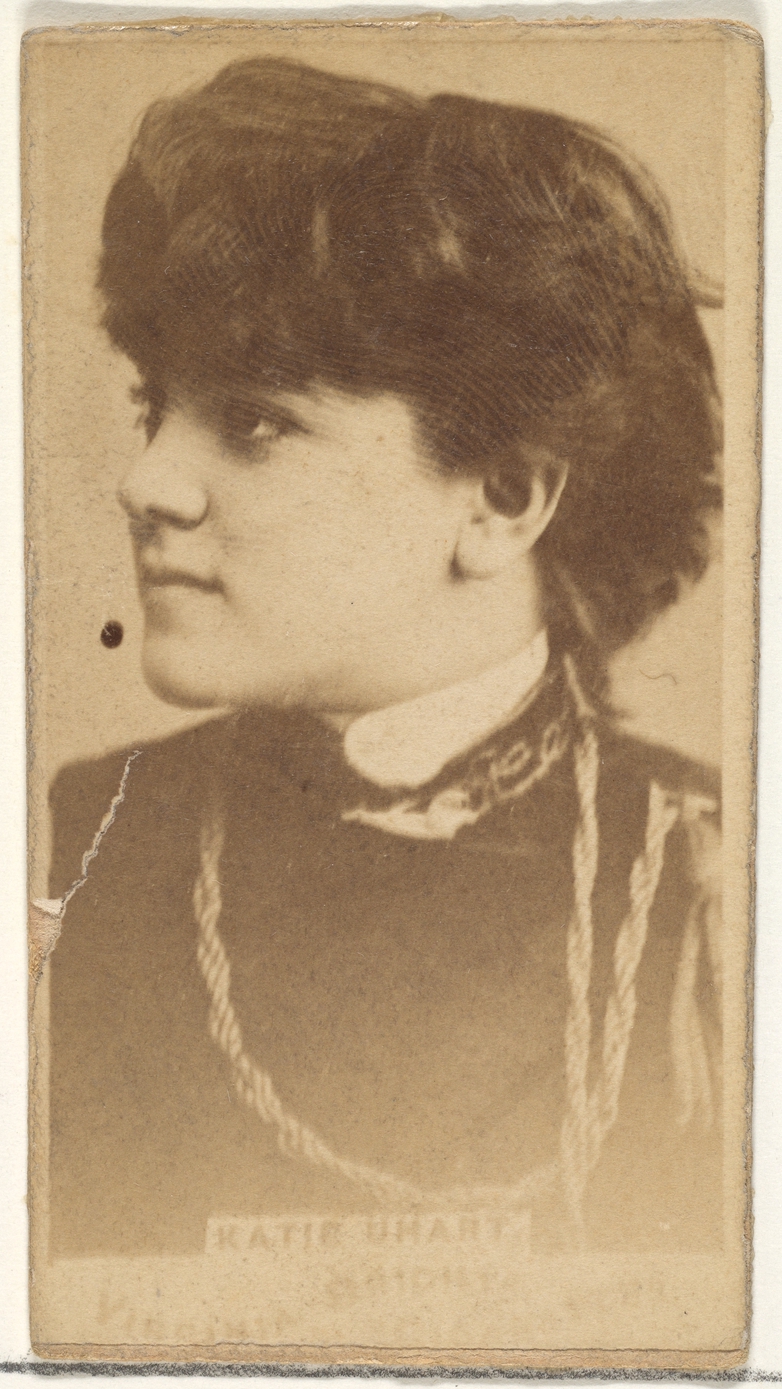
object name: photograph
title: Katie Uhart, from the Actors and Actresses series (N45, Type 1) for Virginia Brights Cigarettes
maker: allen & ginter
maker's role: publisher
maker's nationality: american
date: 1888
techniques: albumen silver print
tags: portraits,women,actresses